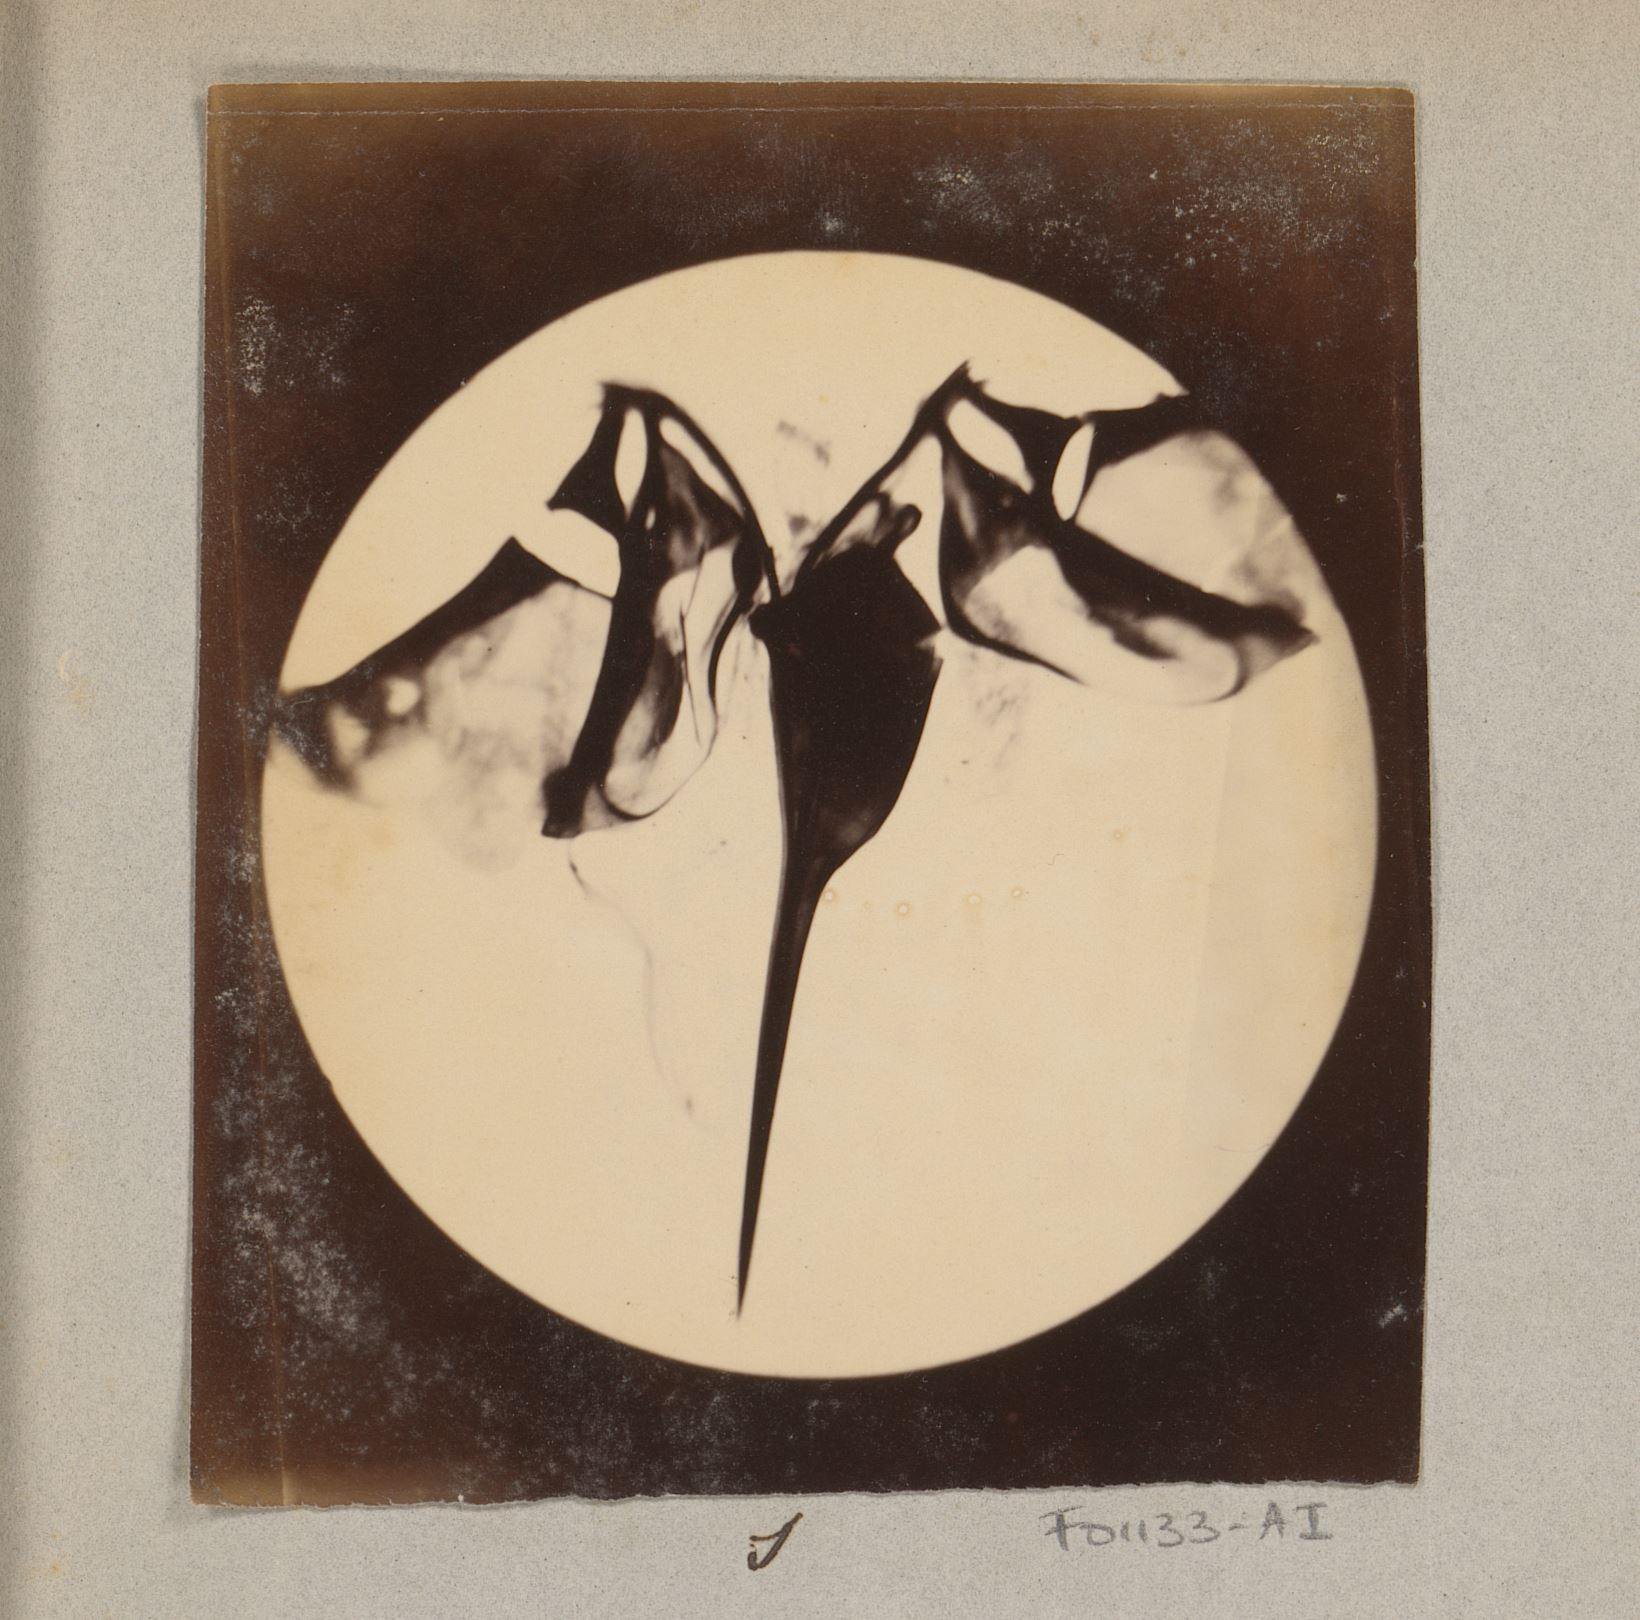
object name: album leaf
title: Microscopische opname van angel van een honingbij, 25 keer vergroot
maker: marinus pieter filbri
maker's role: instrument maker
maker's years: 1852-1917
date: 1887-1888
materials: paper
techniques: albumen print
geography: netherlands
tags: insects: bee, netherlands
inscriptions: inscription: ‘No. 1. Benaming Stekel der Honingbij, vergroot 25 x, Pose 3 min., bemerking Monckhoven’, number: ‘1’